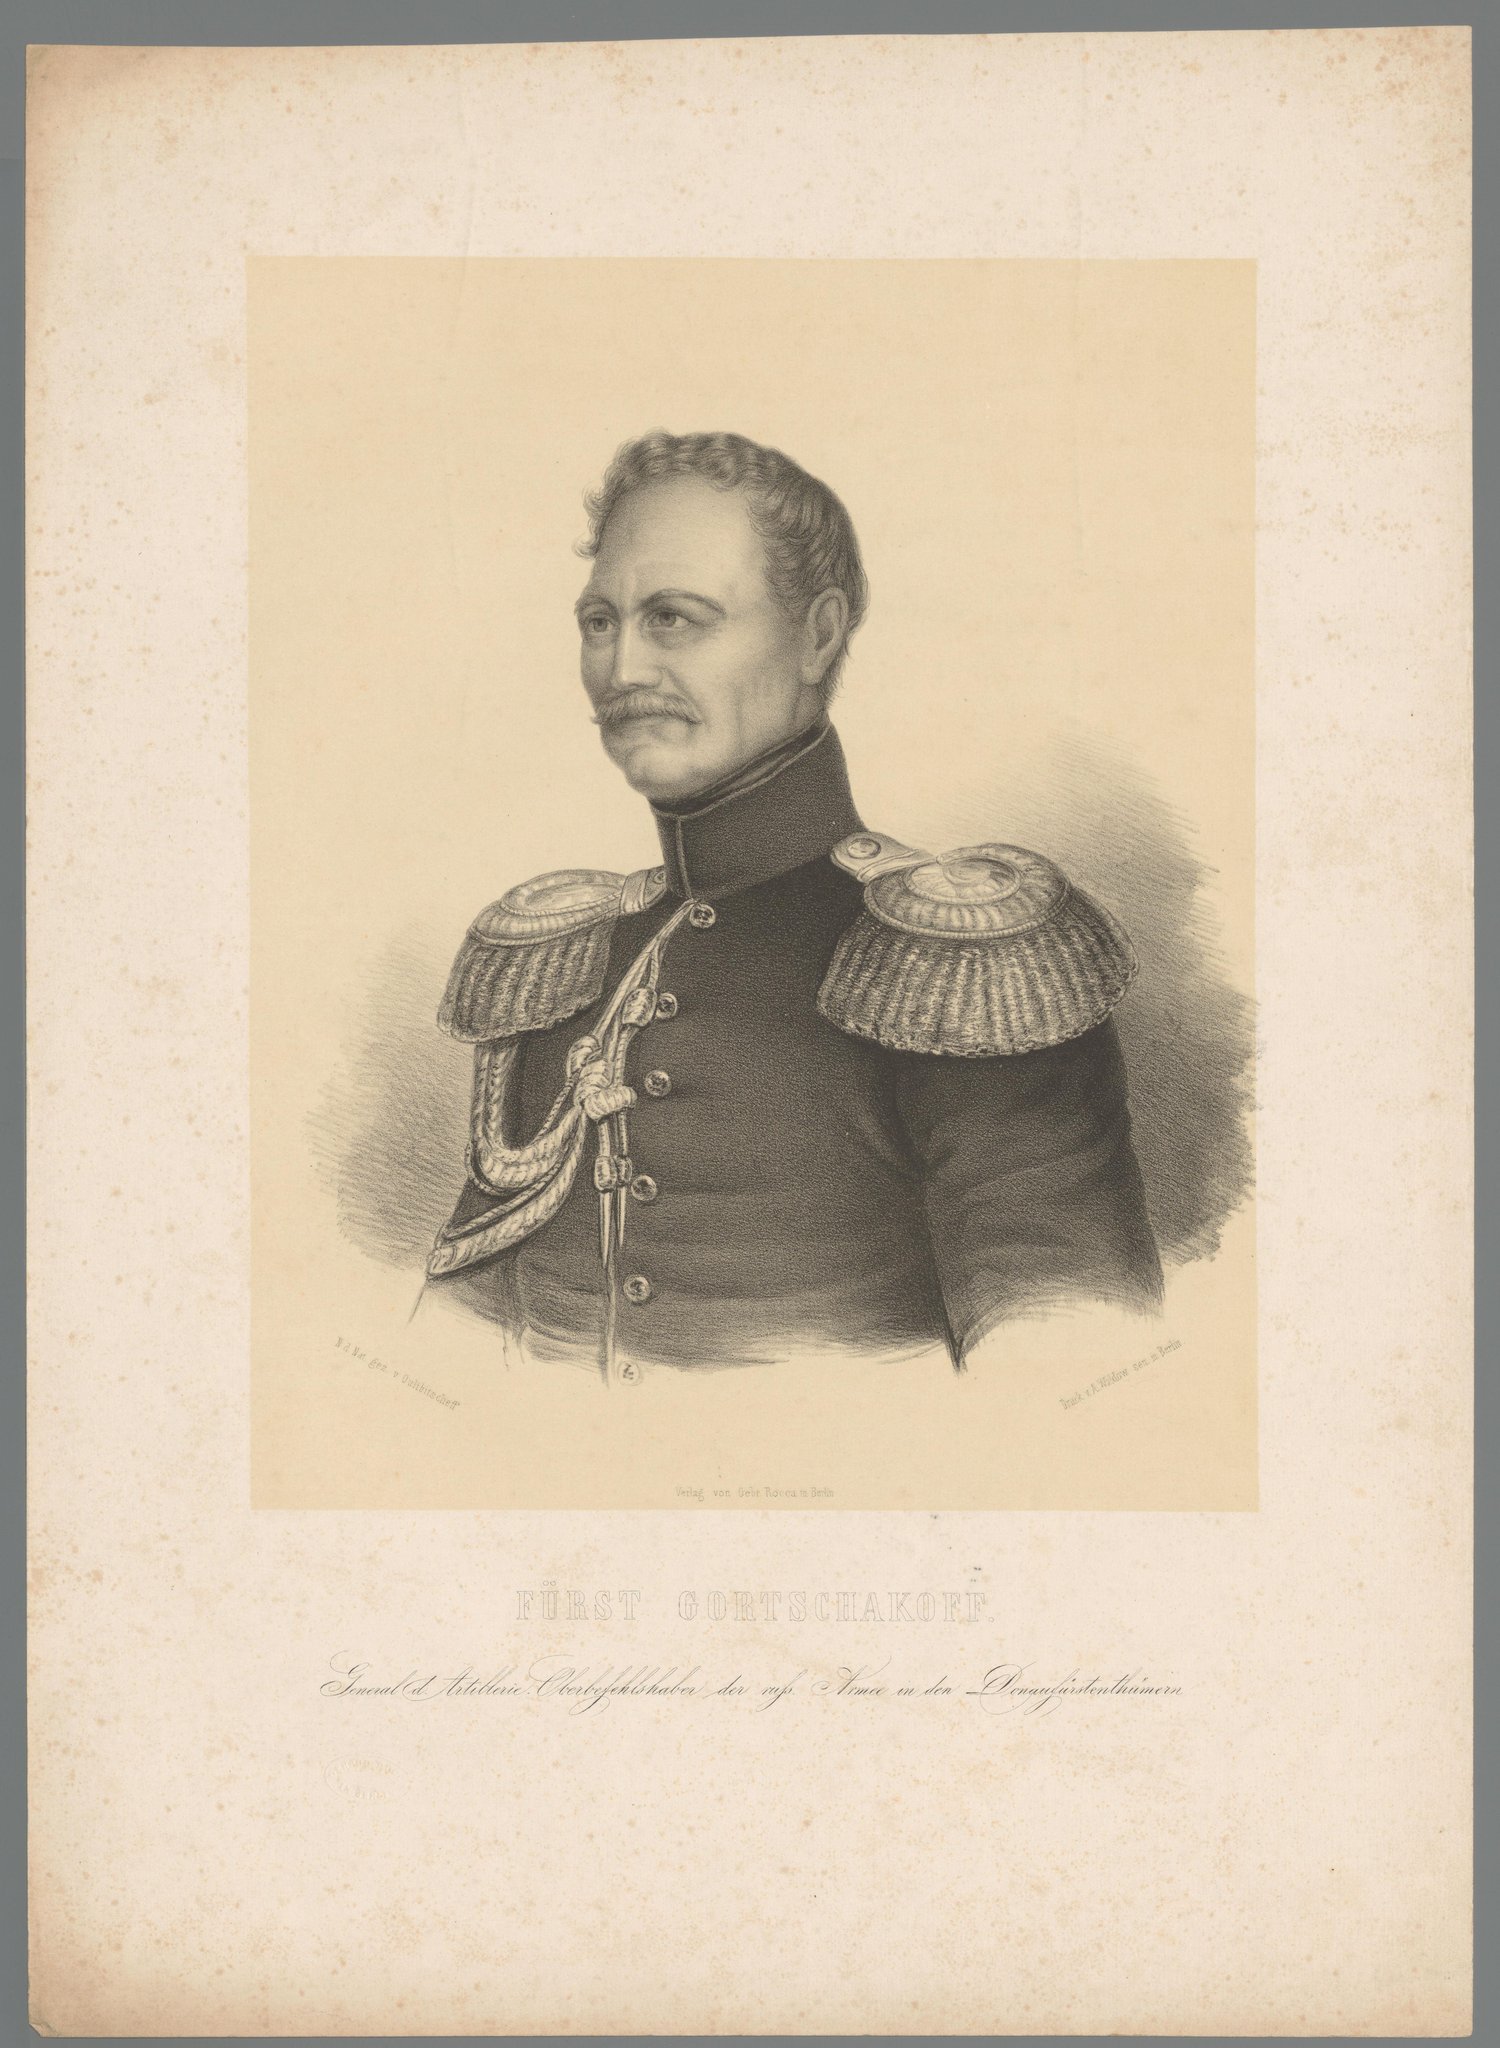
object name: print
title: Fürst Gortschakoff. General d. Artillerie, Oberbefehlshaber der russ. Armee in den Donaufürsten thümern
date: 1830-1863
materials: paper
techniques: tone lithography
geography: berlin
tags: mikhail dmitrievich gorchakov, moustache, adult man, historical persons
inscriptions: collector's mark: Lugt 2228, check stamp: Lugt 2141c